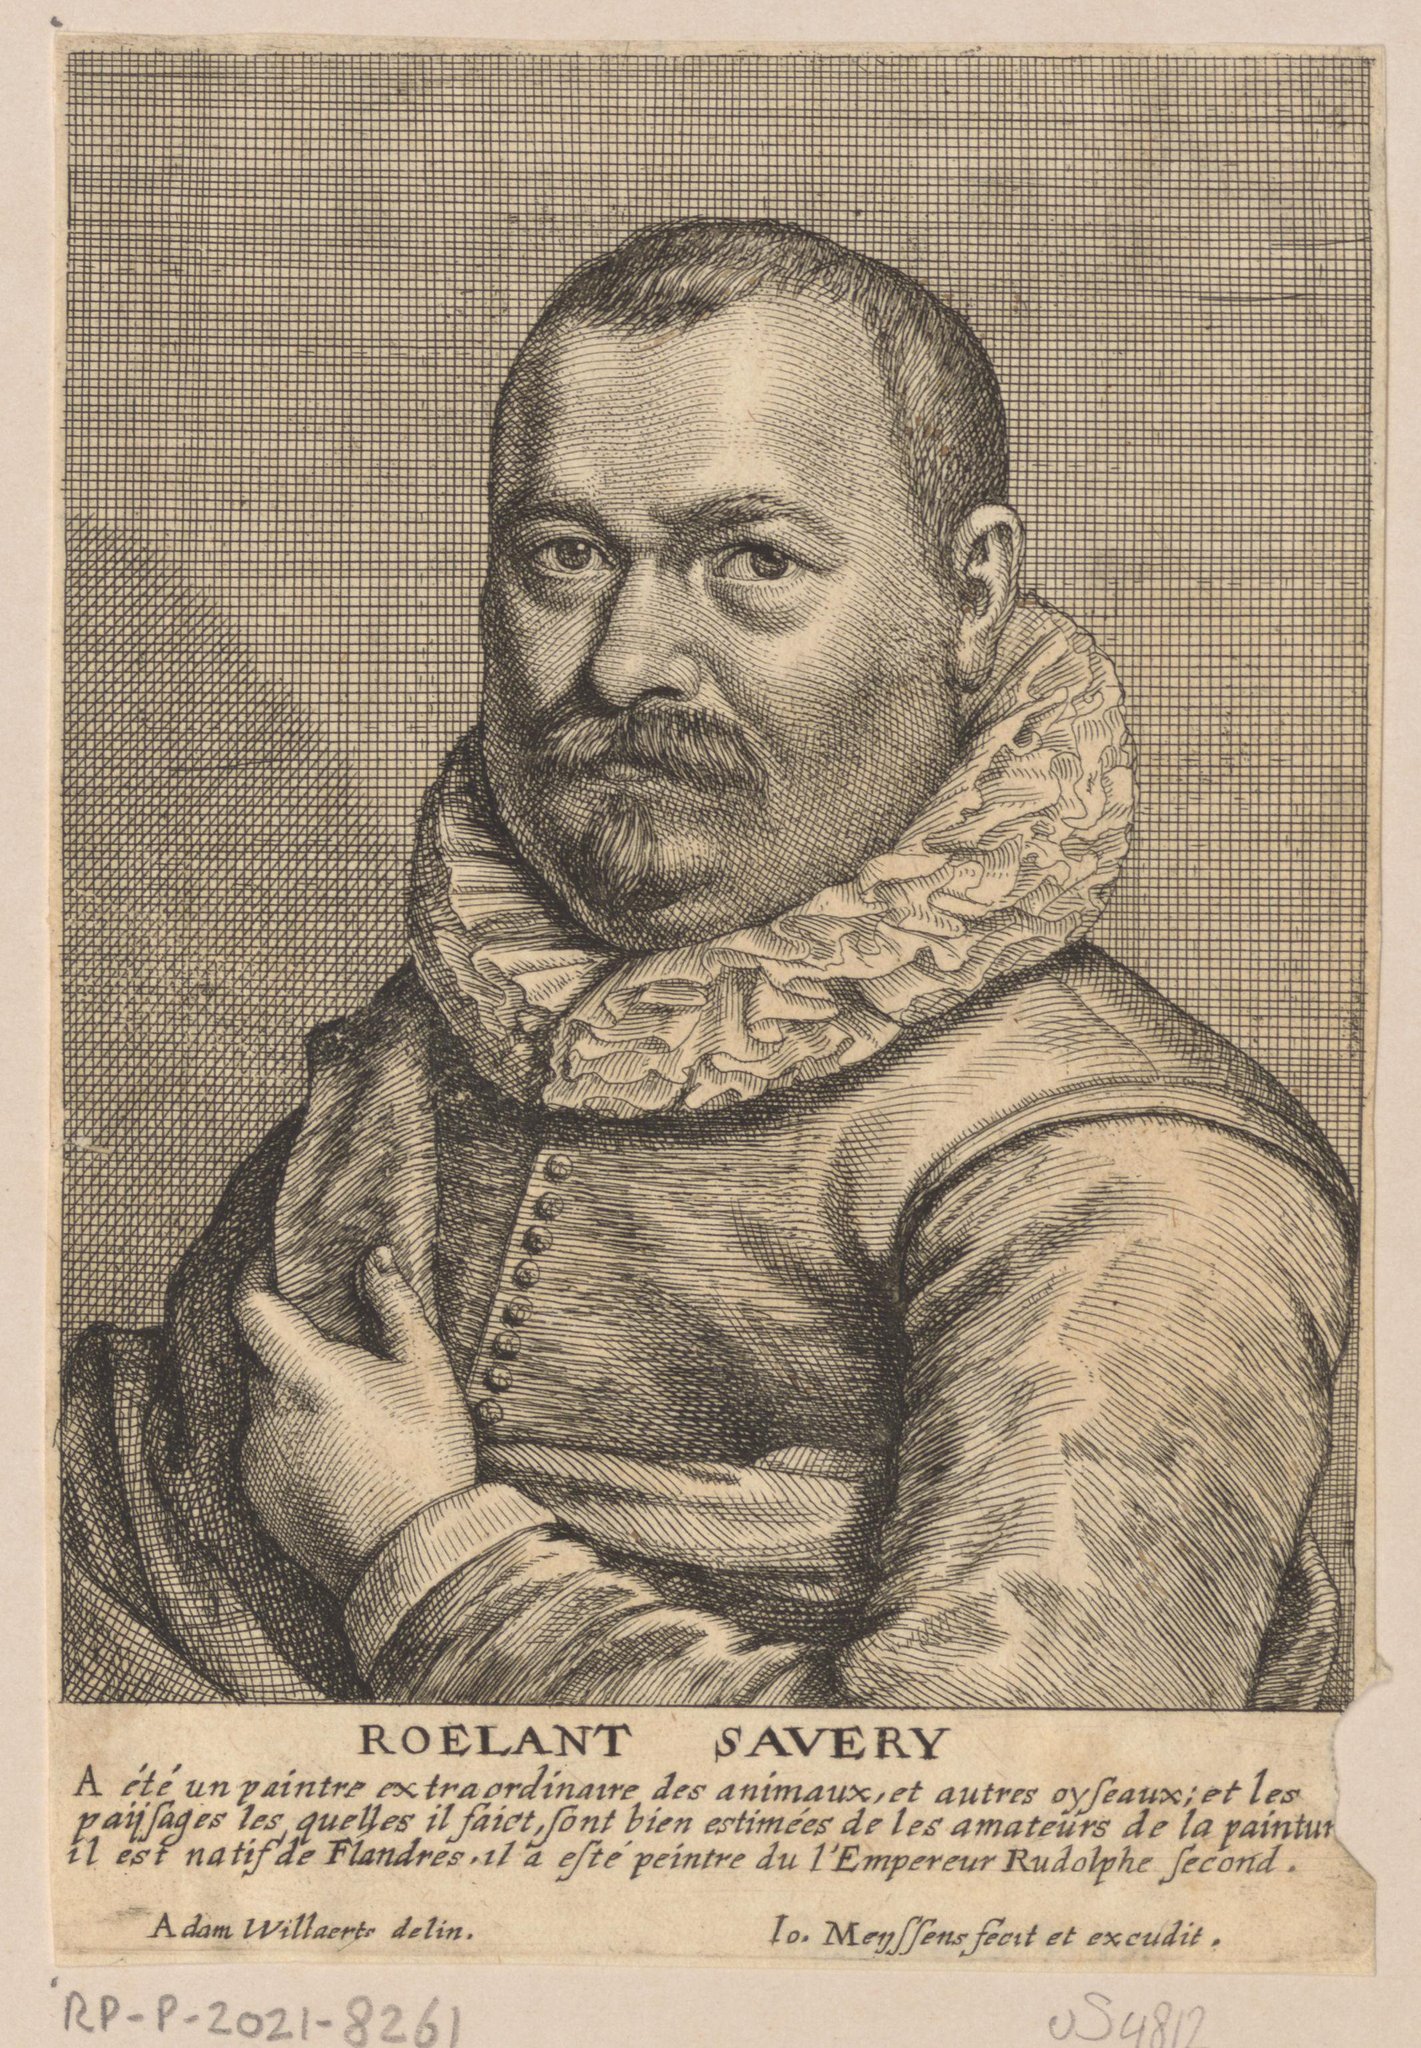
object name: print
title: Portret van Roelant Savery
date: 1649-1662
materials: paper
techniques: engraving, etching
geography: amsterdam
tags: utrecht, painter, print maker, roelant savery, historical persons, portrait, self-portrait of painter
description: Prent mogelijk uit: Image de divers hommes d'esprit sublime, qui par leur art et science devraient vivre éternellement et desquels la louange et renommée faict estonner le monde. Antwerpen: Joannes Meyssens, 1649. Prent met tekst op verso gebruikt in: Bie, Cornelis de. Het gulden cabinet vande edel vry schilder const (...). Antwerpen: Joannes Meyssens, 1662 [1661 foutief op titelpagina], p. 125.